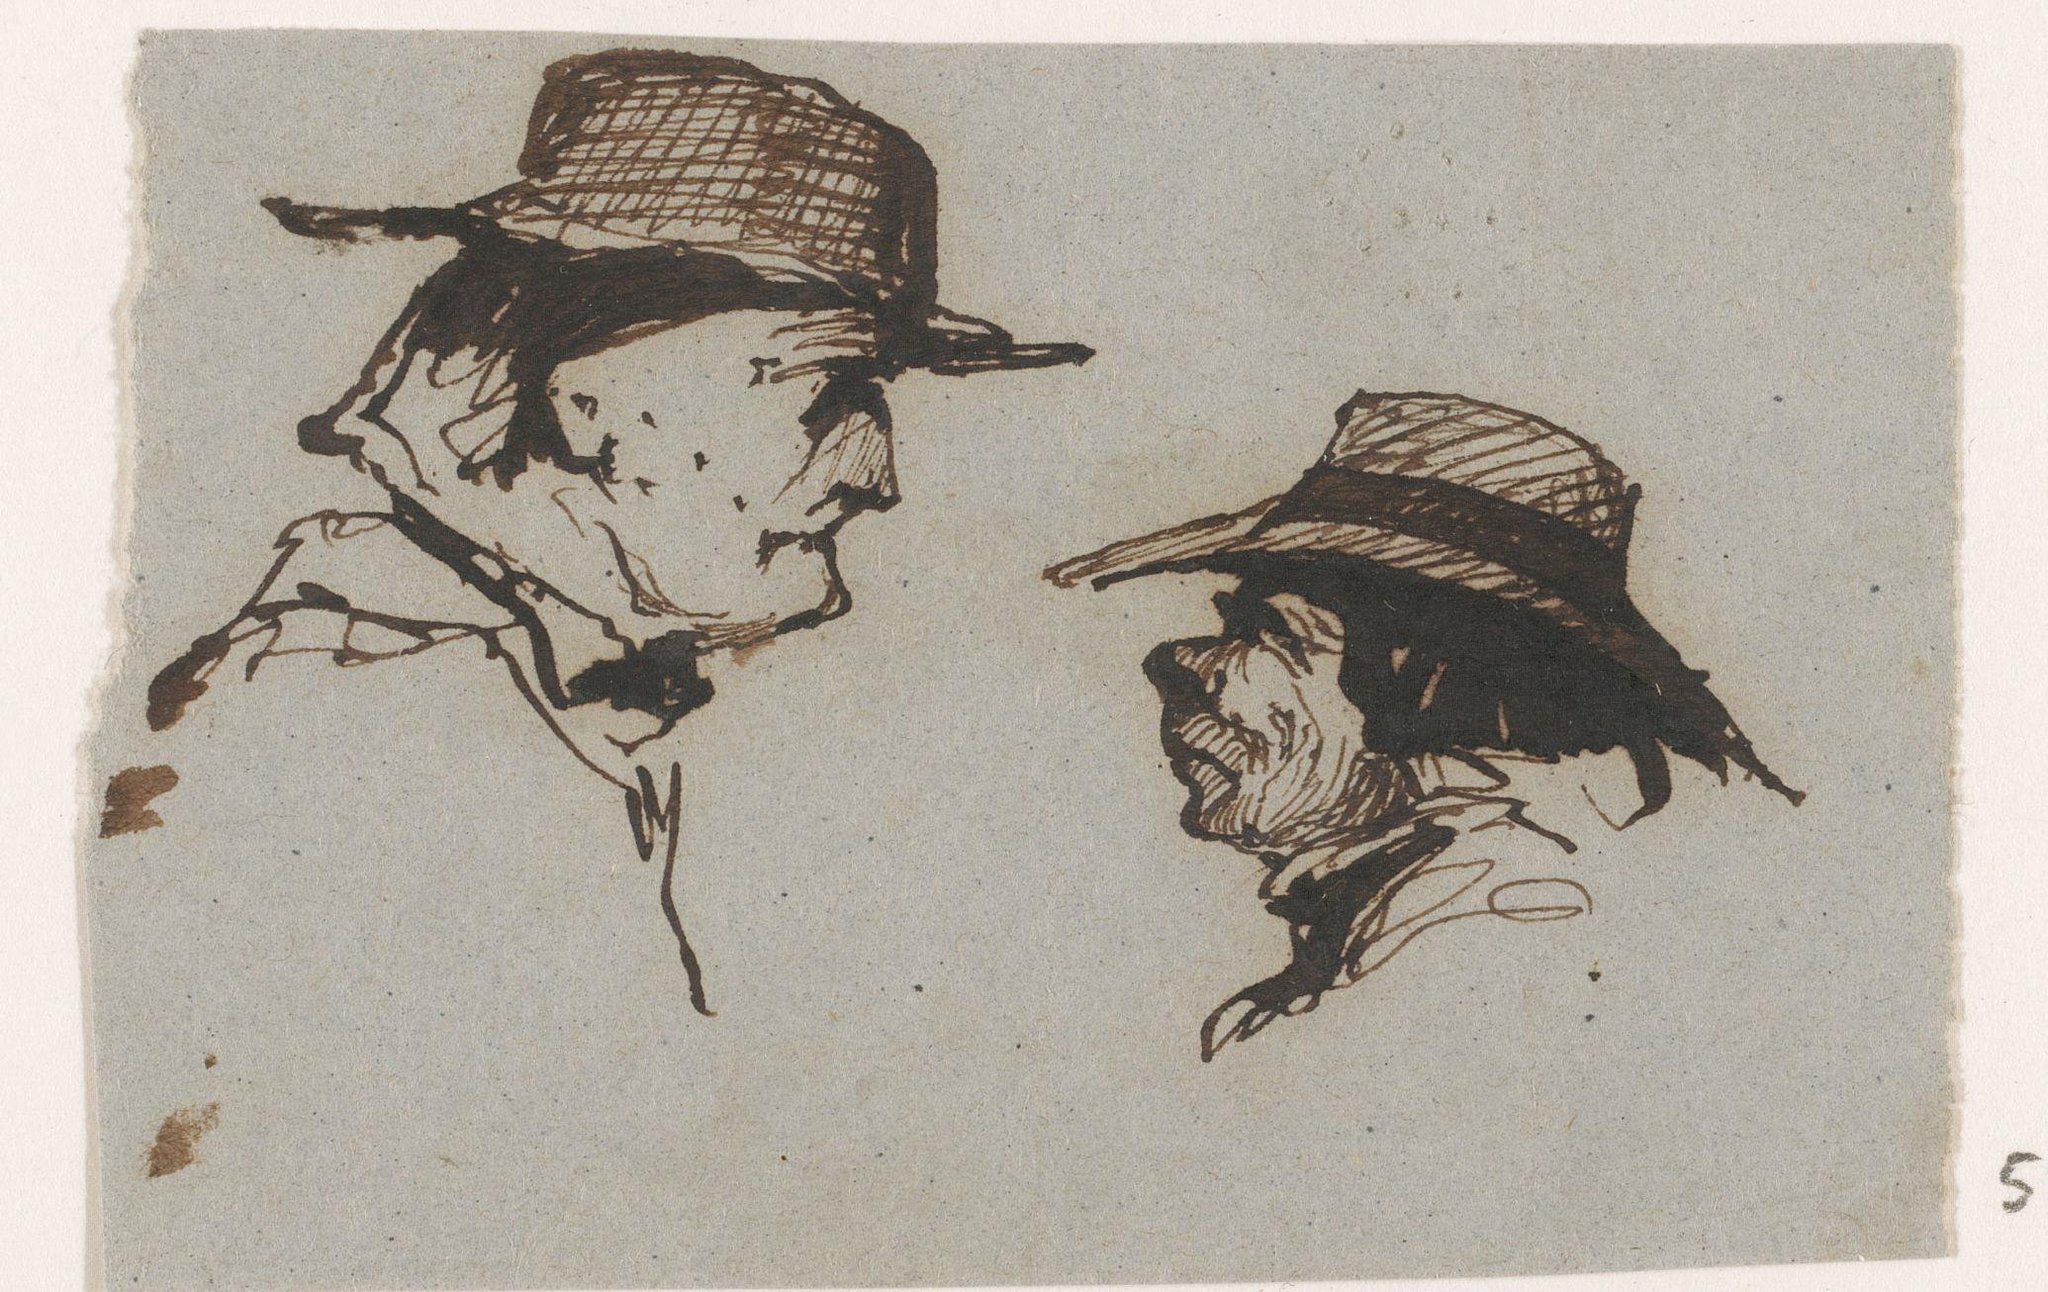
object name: drawing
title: Twee koppen met hoeden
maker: johannes tavenraat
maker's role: draughtsman, painter, print maker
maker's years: 1809-1881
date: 1840-1880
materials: ink, paper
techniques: pen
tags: caricatures (human types)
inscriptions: annotation: ‘uit Henri's Portefeuille’, collector's mark: Lugt 2228